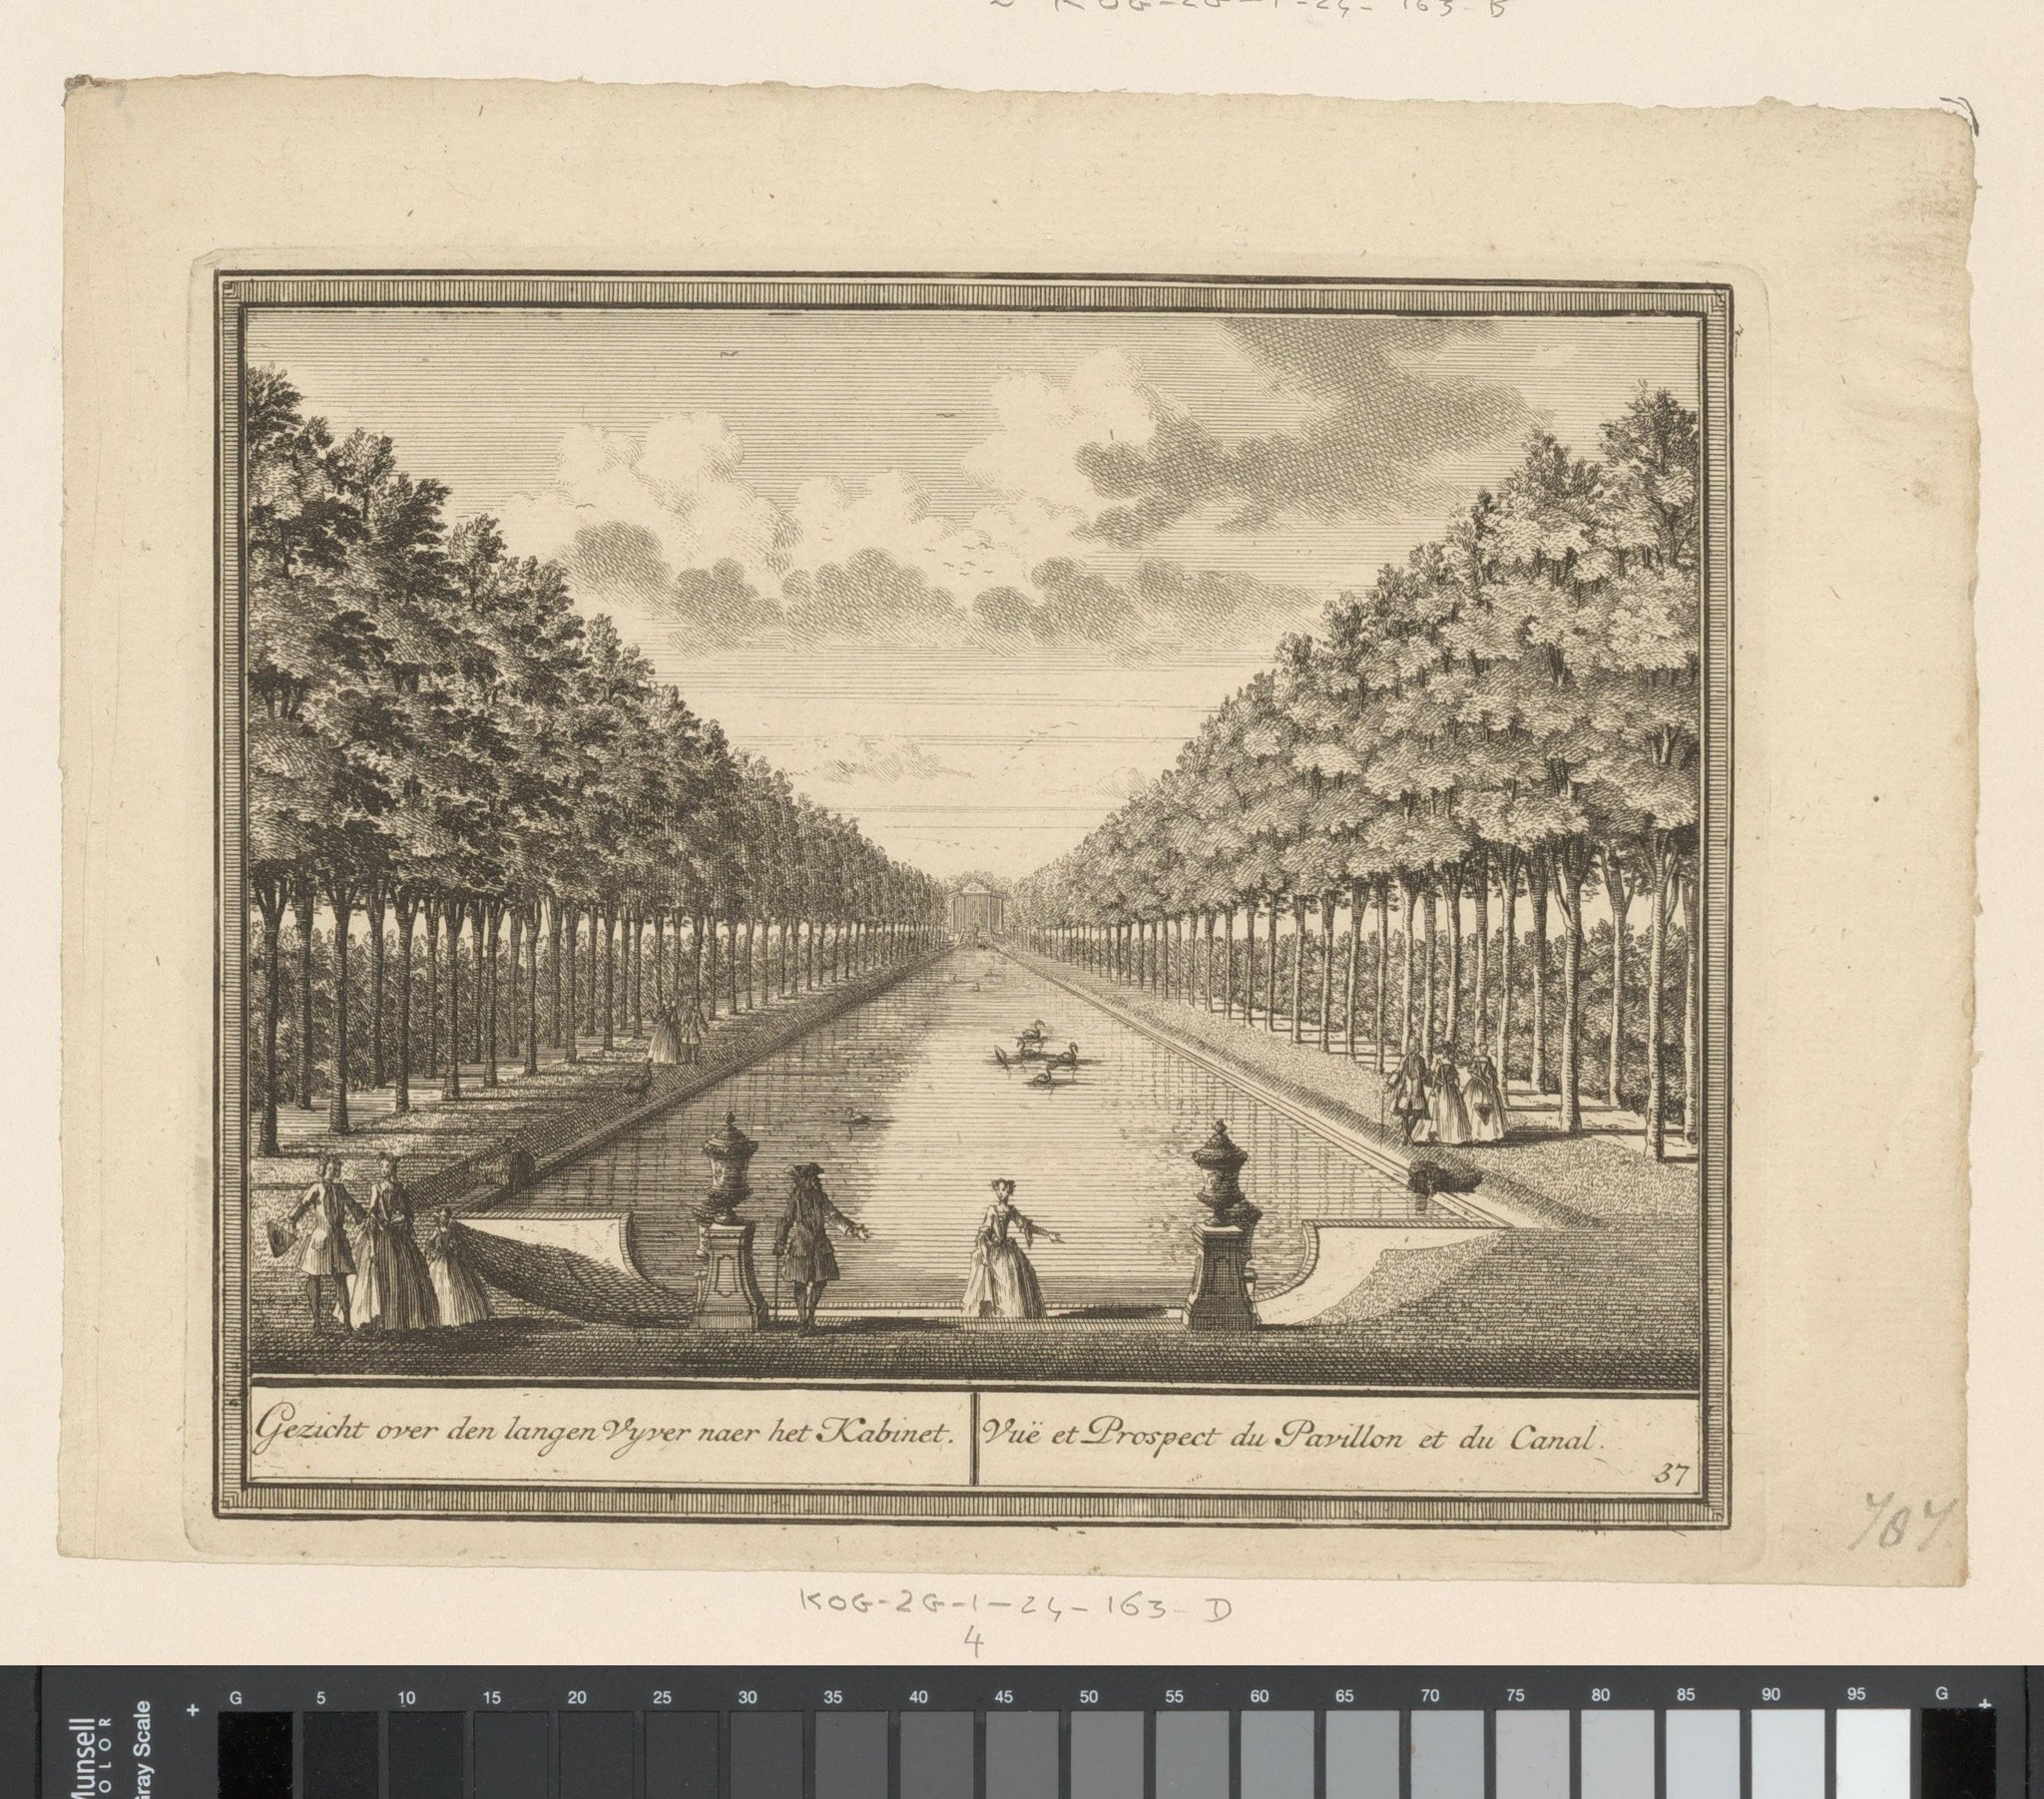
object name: print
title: Gezicht op de lange vijver van buitenplaats Watervliet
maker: hendrik de leth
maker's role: draughtsman, print maker, publisher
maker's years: 1703-1766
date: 1729-1732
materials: paper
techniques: engraving, etching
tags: garden pond, country-house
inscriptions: stamp, stamp, collector's mark: Lugt 1641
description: Prent mogelijk uit: Brouërius van Nidek, Matthaeus. Het zegepralend Kennemerland, vertoond in 100 heerlyke gezichten. Amsterdam: Jan Roman, s.a. Of uit: Brouërius van Nidek, Matthaeus. Het zegepralend Kennemerland, vertoond in veele heerlyke gezichten. Amsterdam: Andries en Hendrik de Leth, s.a [1729-1732].